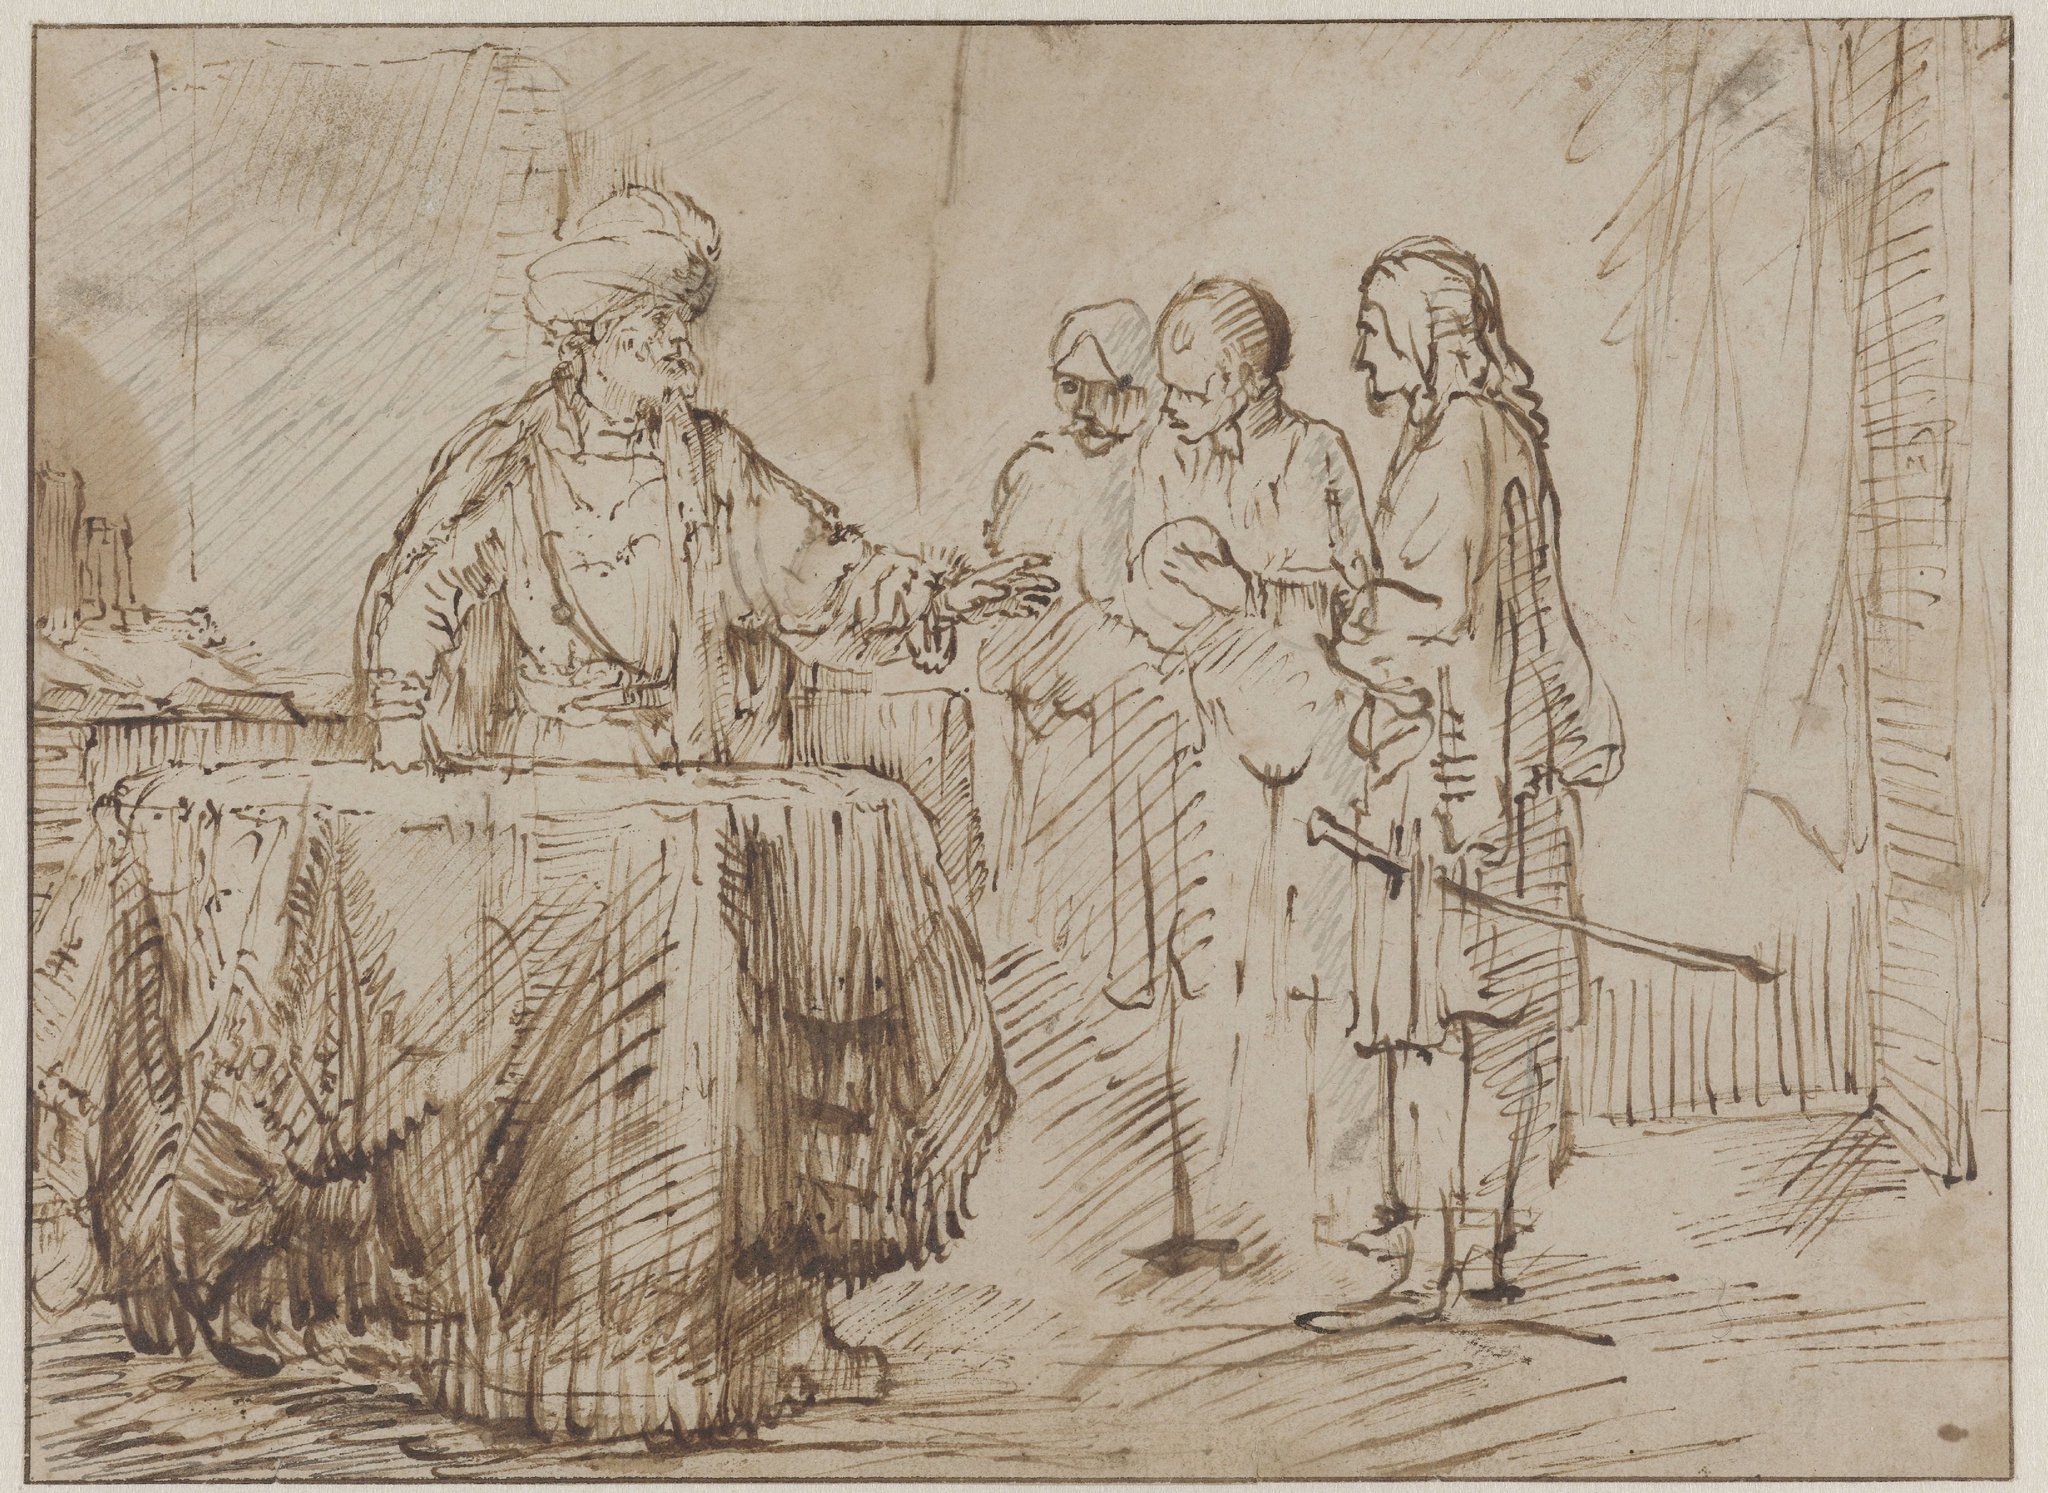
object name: drawing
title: The Roman Centurion Cornelius Sending his Men to Joppa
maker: willem drost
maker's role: draughtsman, painter, print maker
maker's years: 1633-1659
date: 1653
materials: ink, paper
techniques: pen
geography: amsterdam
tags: the unmerciful servant: the king forgives him his debts ~ parable of christ (matthew 18:23-35)